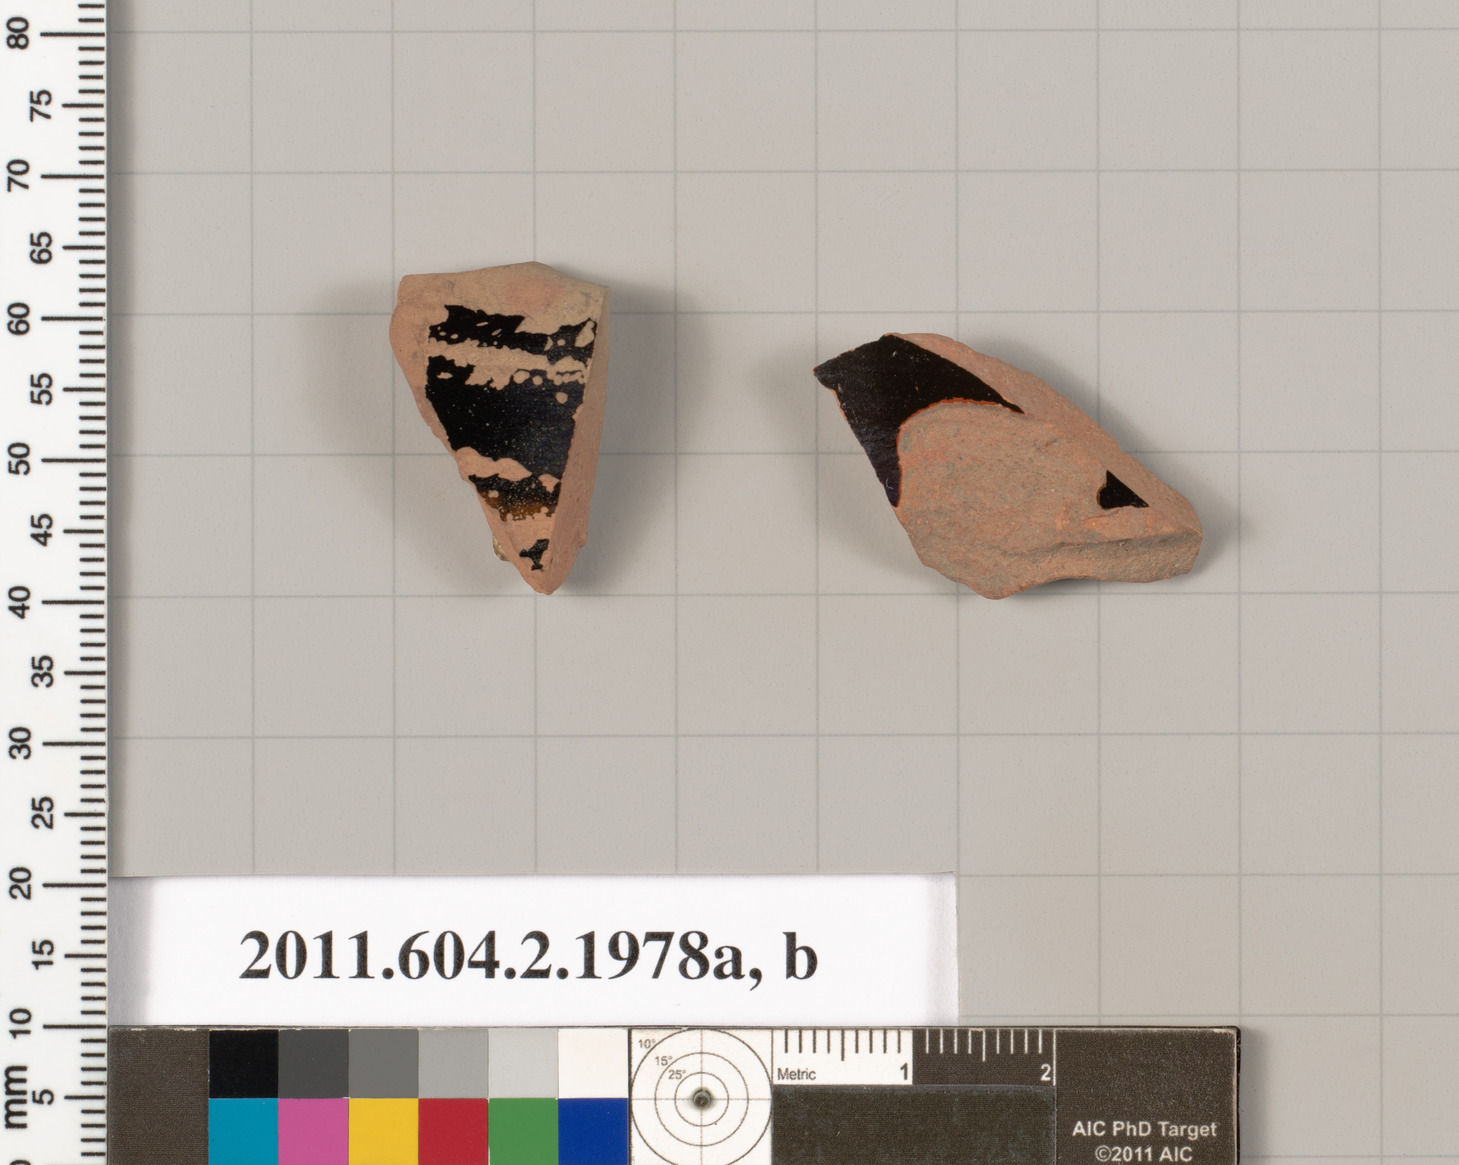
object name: pot fragment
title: Terracotta fragments of pots; glazed on the inside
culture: greek, attic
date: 500-401 BCE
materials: terracotta